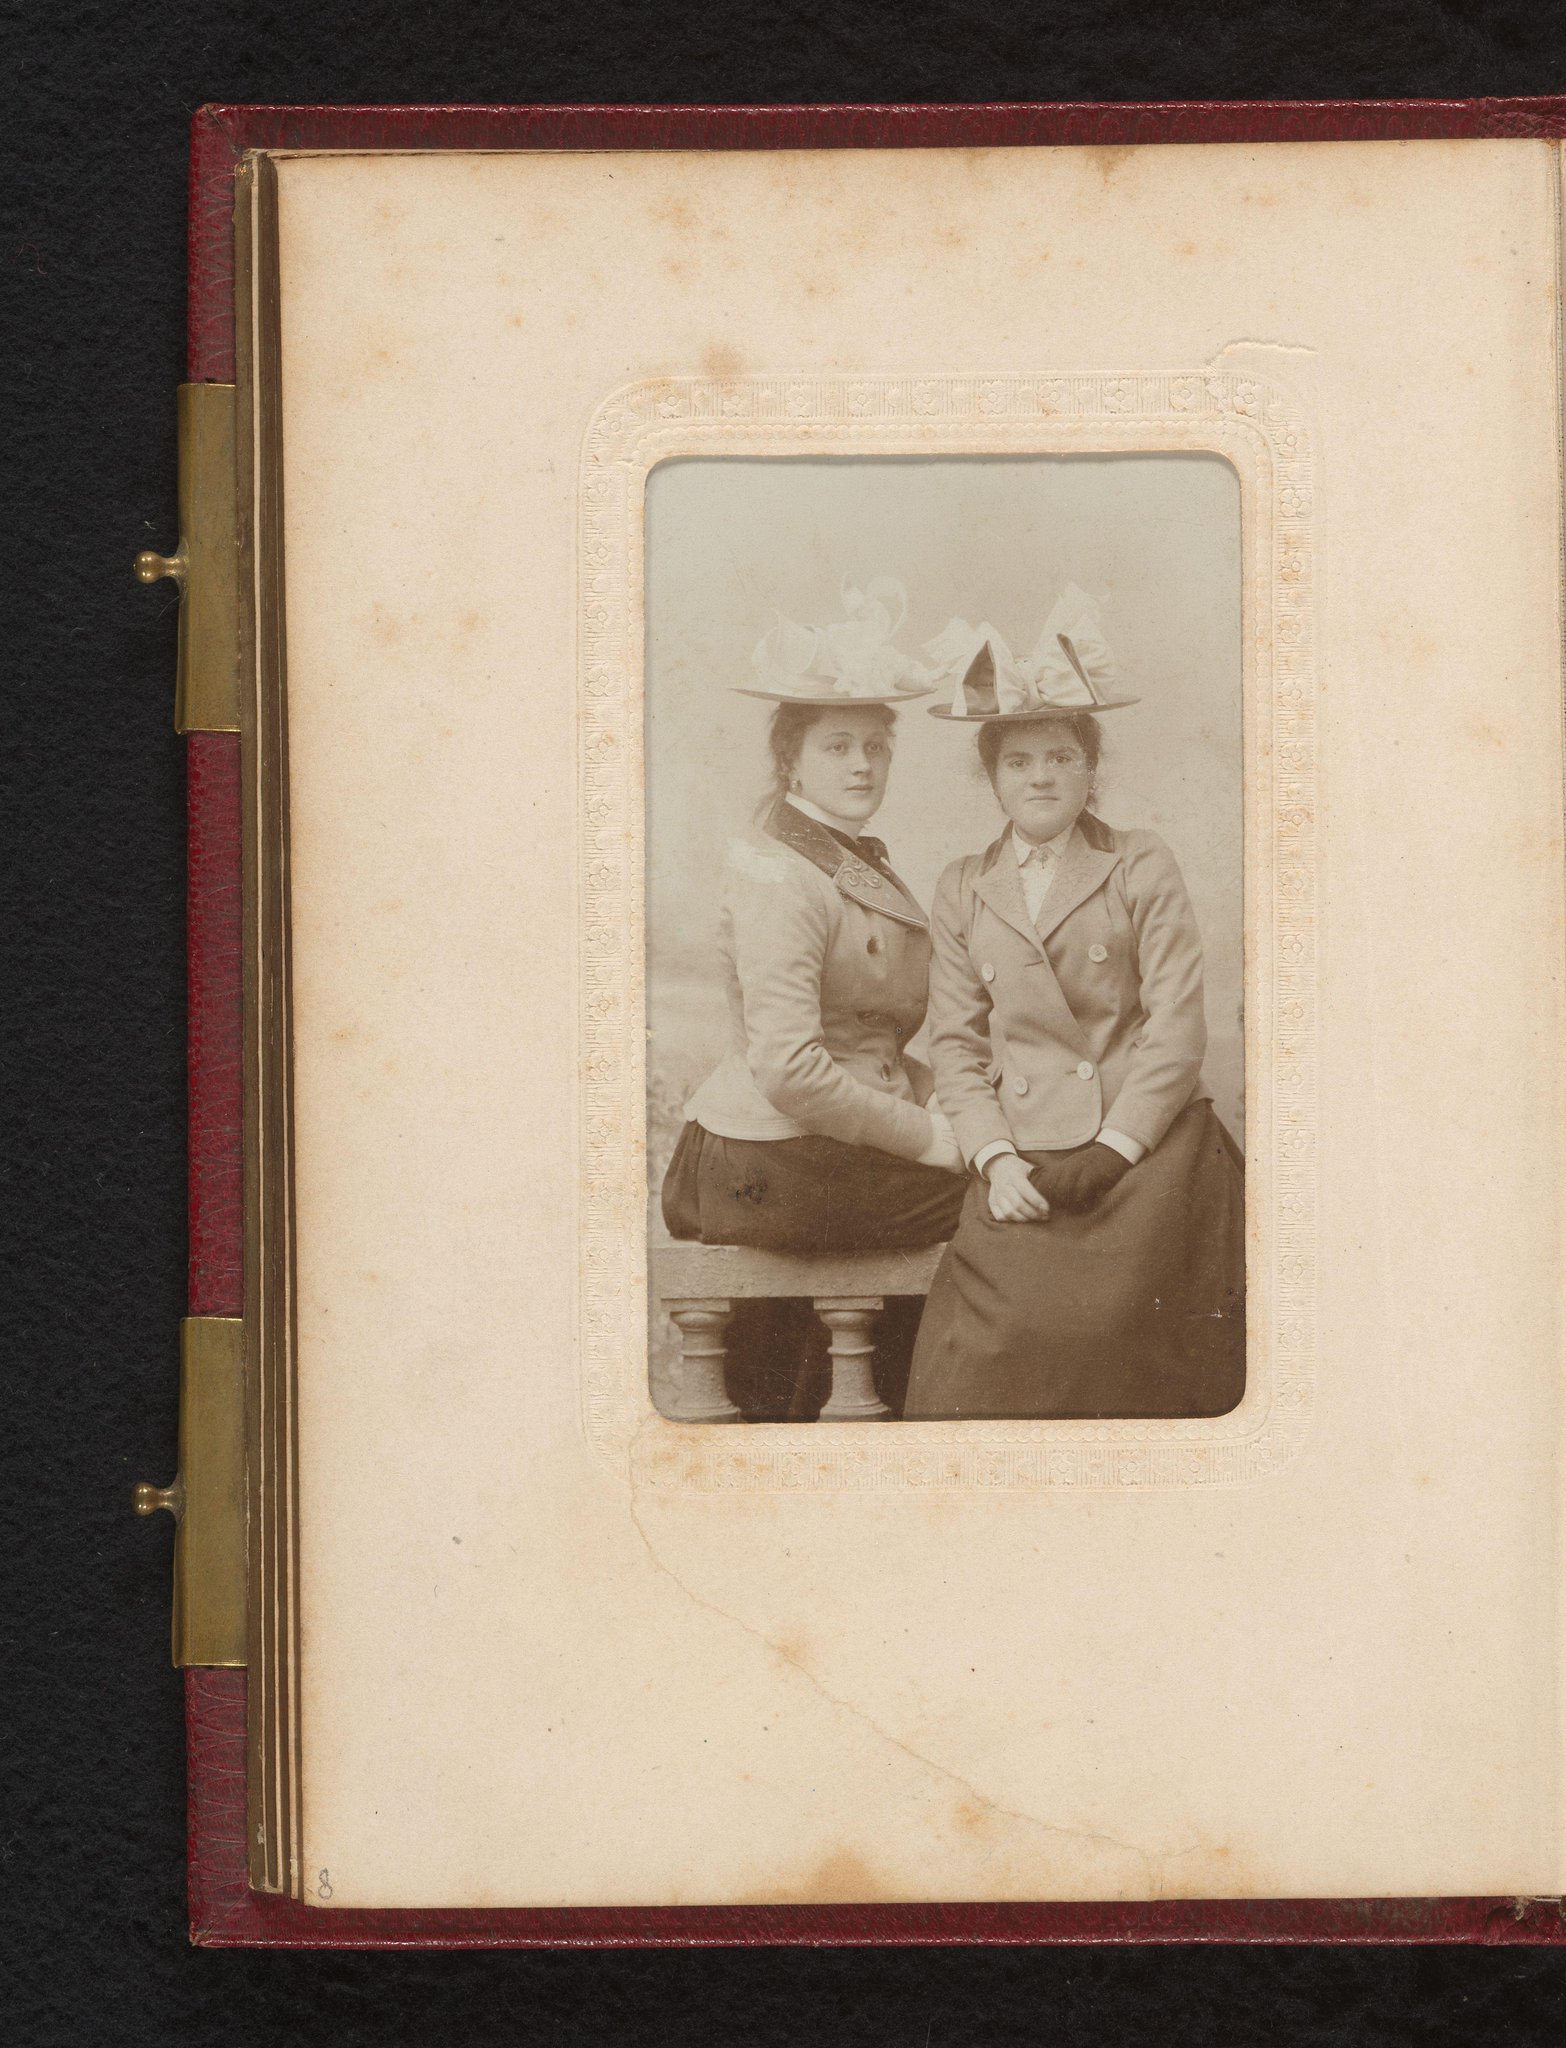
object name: album leaf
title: Portret van twee jonge vrouwen met hoed, leunend op een balustrade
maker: derk jan hekkert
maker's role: fotograaf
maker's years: 1869-1949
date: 1890-1940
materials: cardboard, photographic support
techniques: collodion silver print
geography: amsterdam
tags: historical persons - bb - woman, head-gear: hat, balustrade, adolescent, young woman, maiden (+ two persons)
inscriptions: inscription: ‘D. Hekkert/ Deveneter - Voorstad/ Photogr. Atelier/ Plaat blijft voor Nabestelling bewaard.’